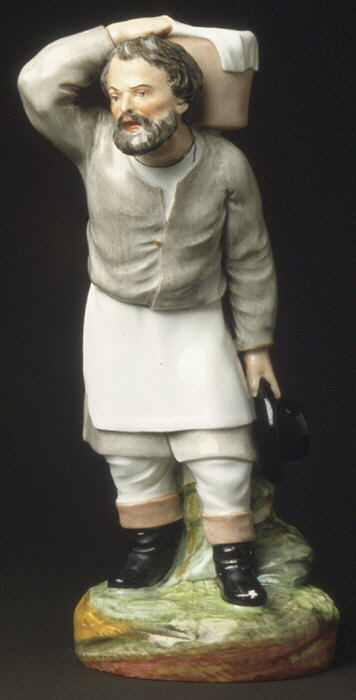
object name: figure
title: Ice Cream Seller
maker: imperial porcelain manufactory, st. petersburg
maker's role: manufactory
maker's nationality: russian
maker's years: 1744-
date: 1780-1800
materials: hard paste porcelain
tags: men